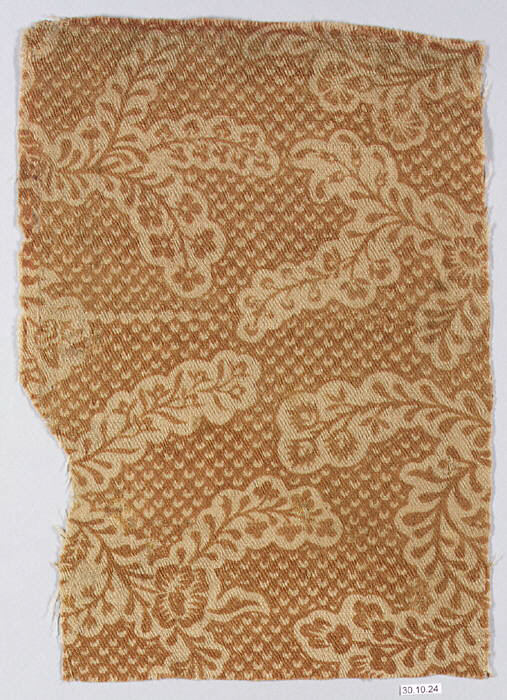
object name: piece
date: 1701-1900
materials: wool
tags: flowers,leaves